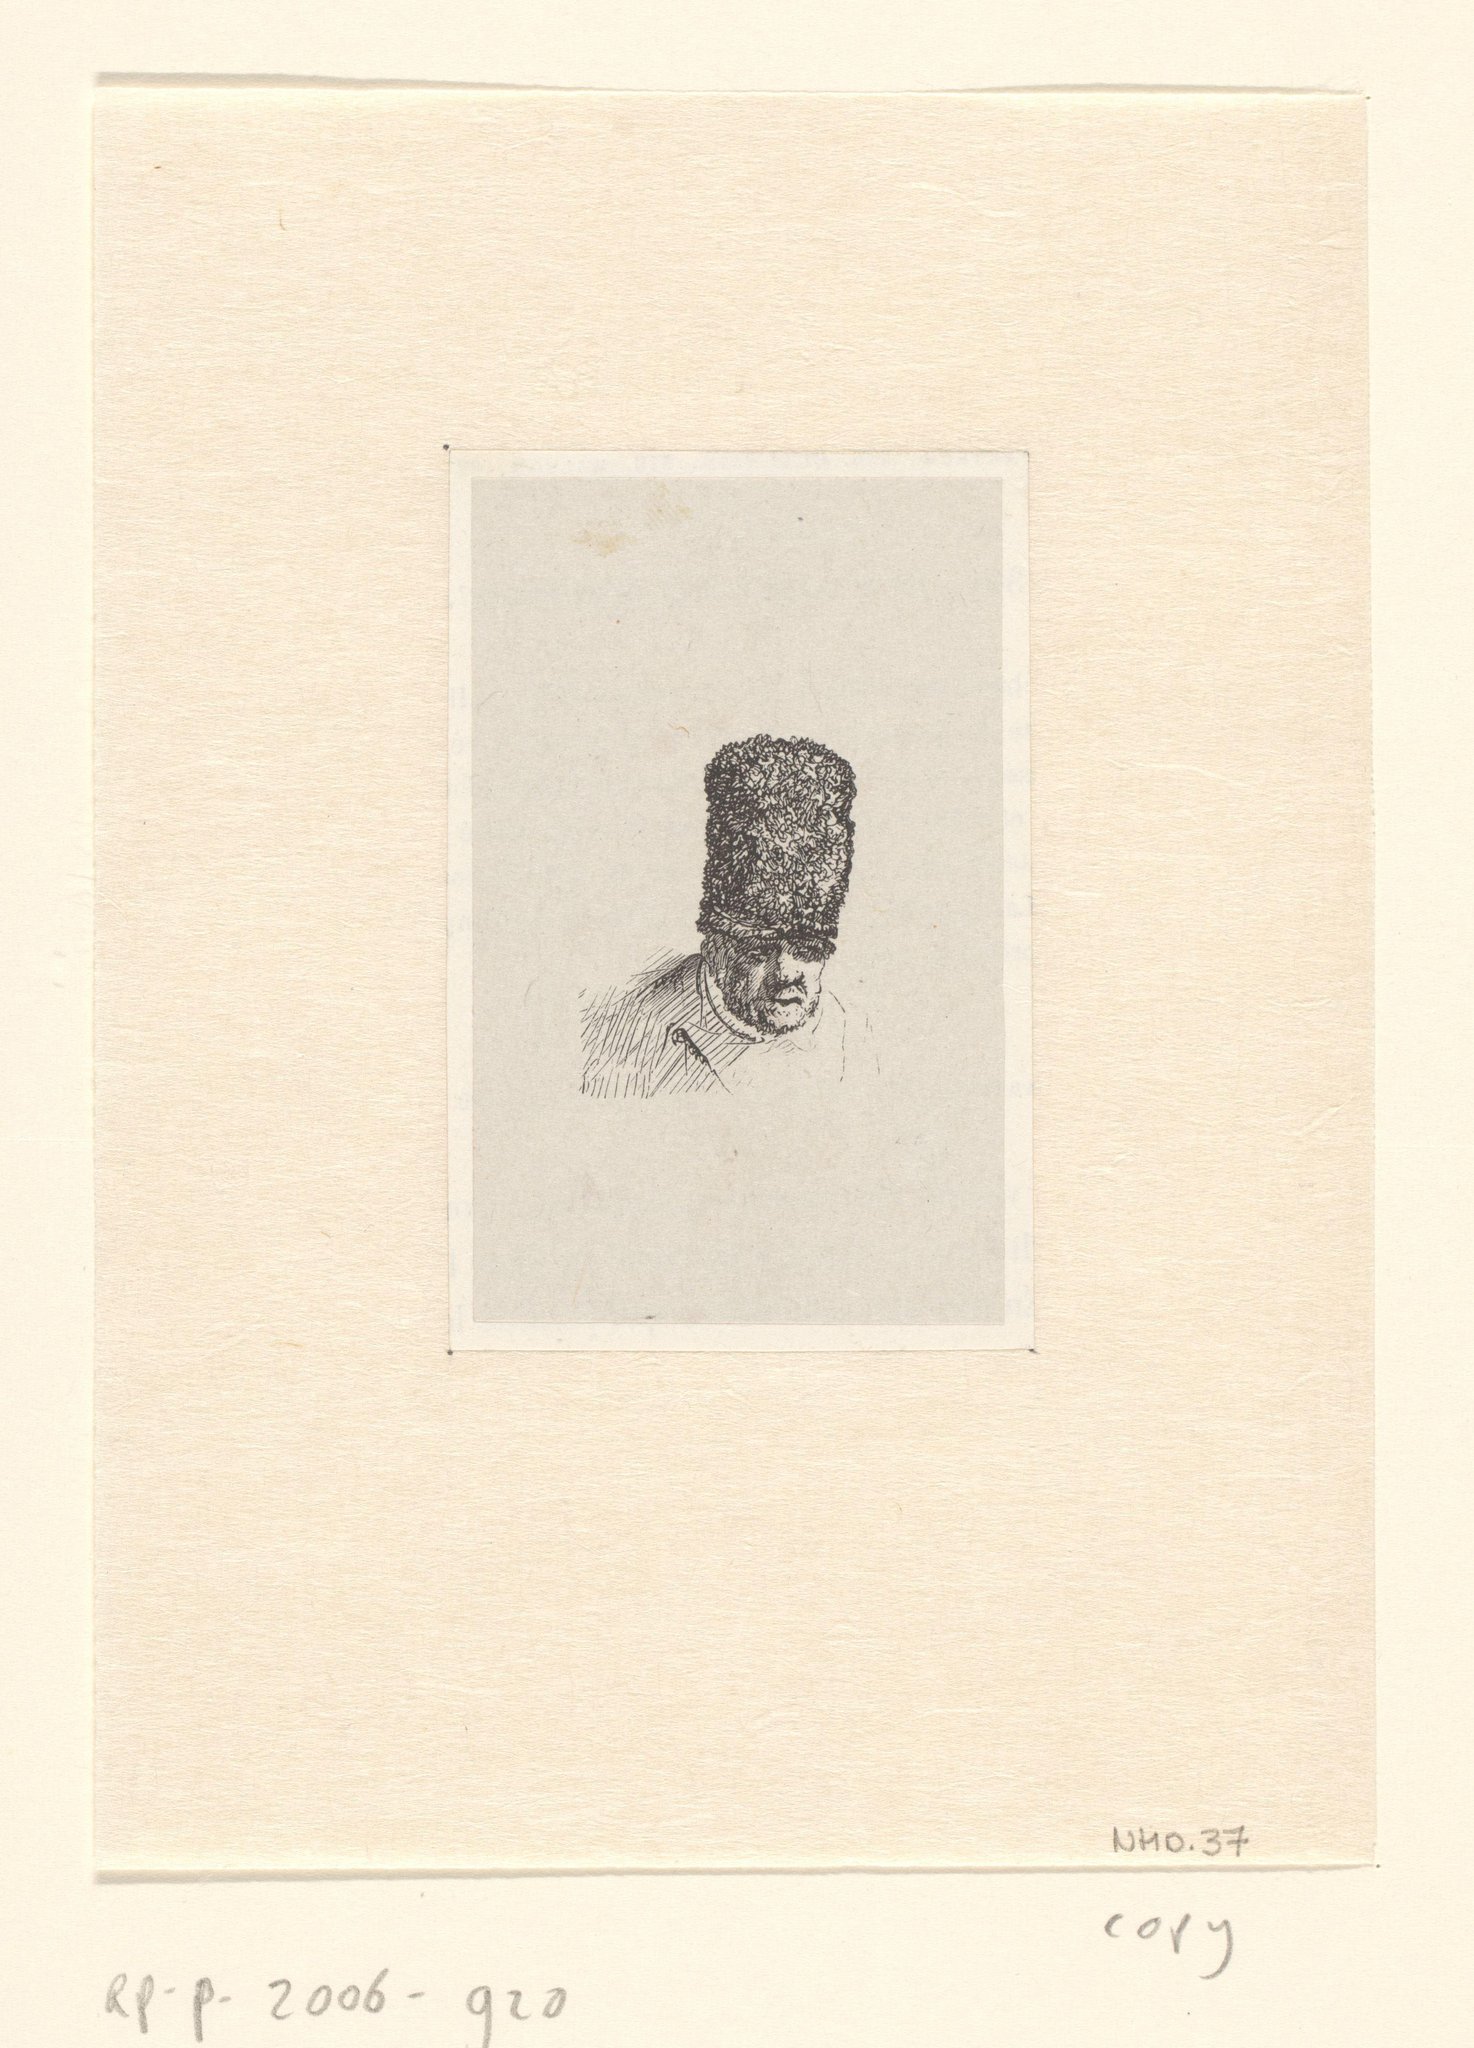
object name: print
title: Head of an old man in a high fur cap: bust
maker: Anonymous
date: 1859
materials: paper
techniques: engraving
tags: head-gear: cap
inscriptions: collector's mark: Lugt 2228, collector's mark: Lugt 2760